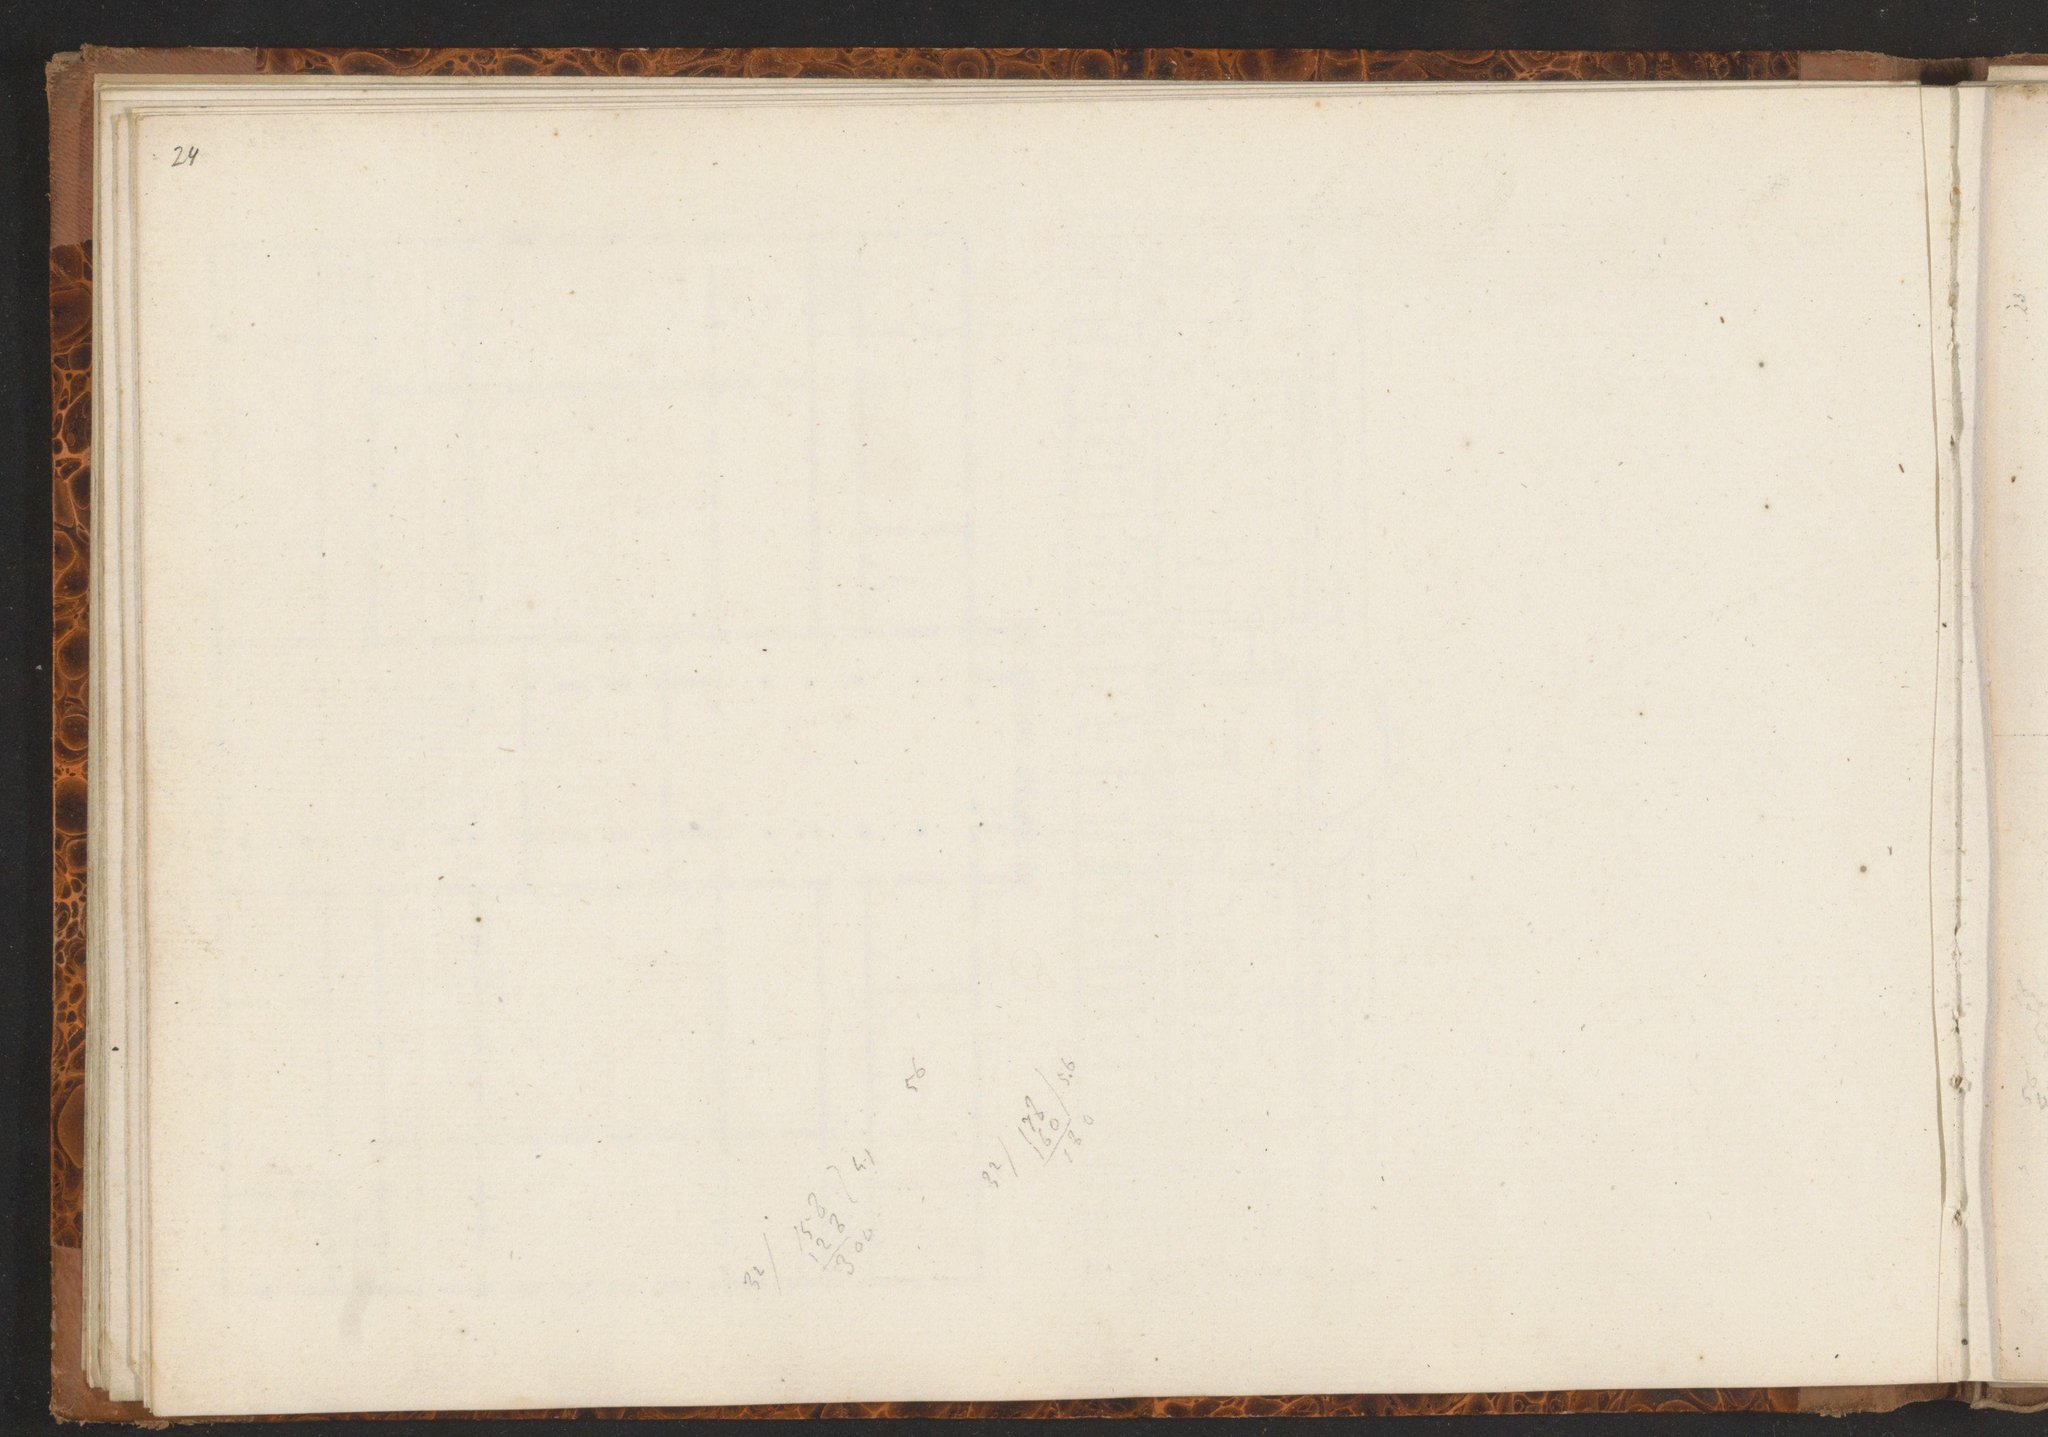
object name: sketchbook leaf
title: Berekeningen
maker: willem springer jr.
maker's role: draughtsman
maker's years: 1815-1907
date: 1825-1907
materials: paper, pencil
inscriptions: annotation: ‘[...]’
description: Pagina 24 uit een schetsboek met 86 pagina's.